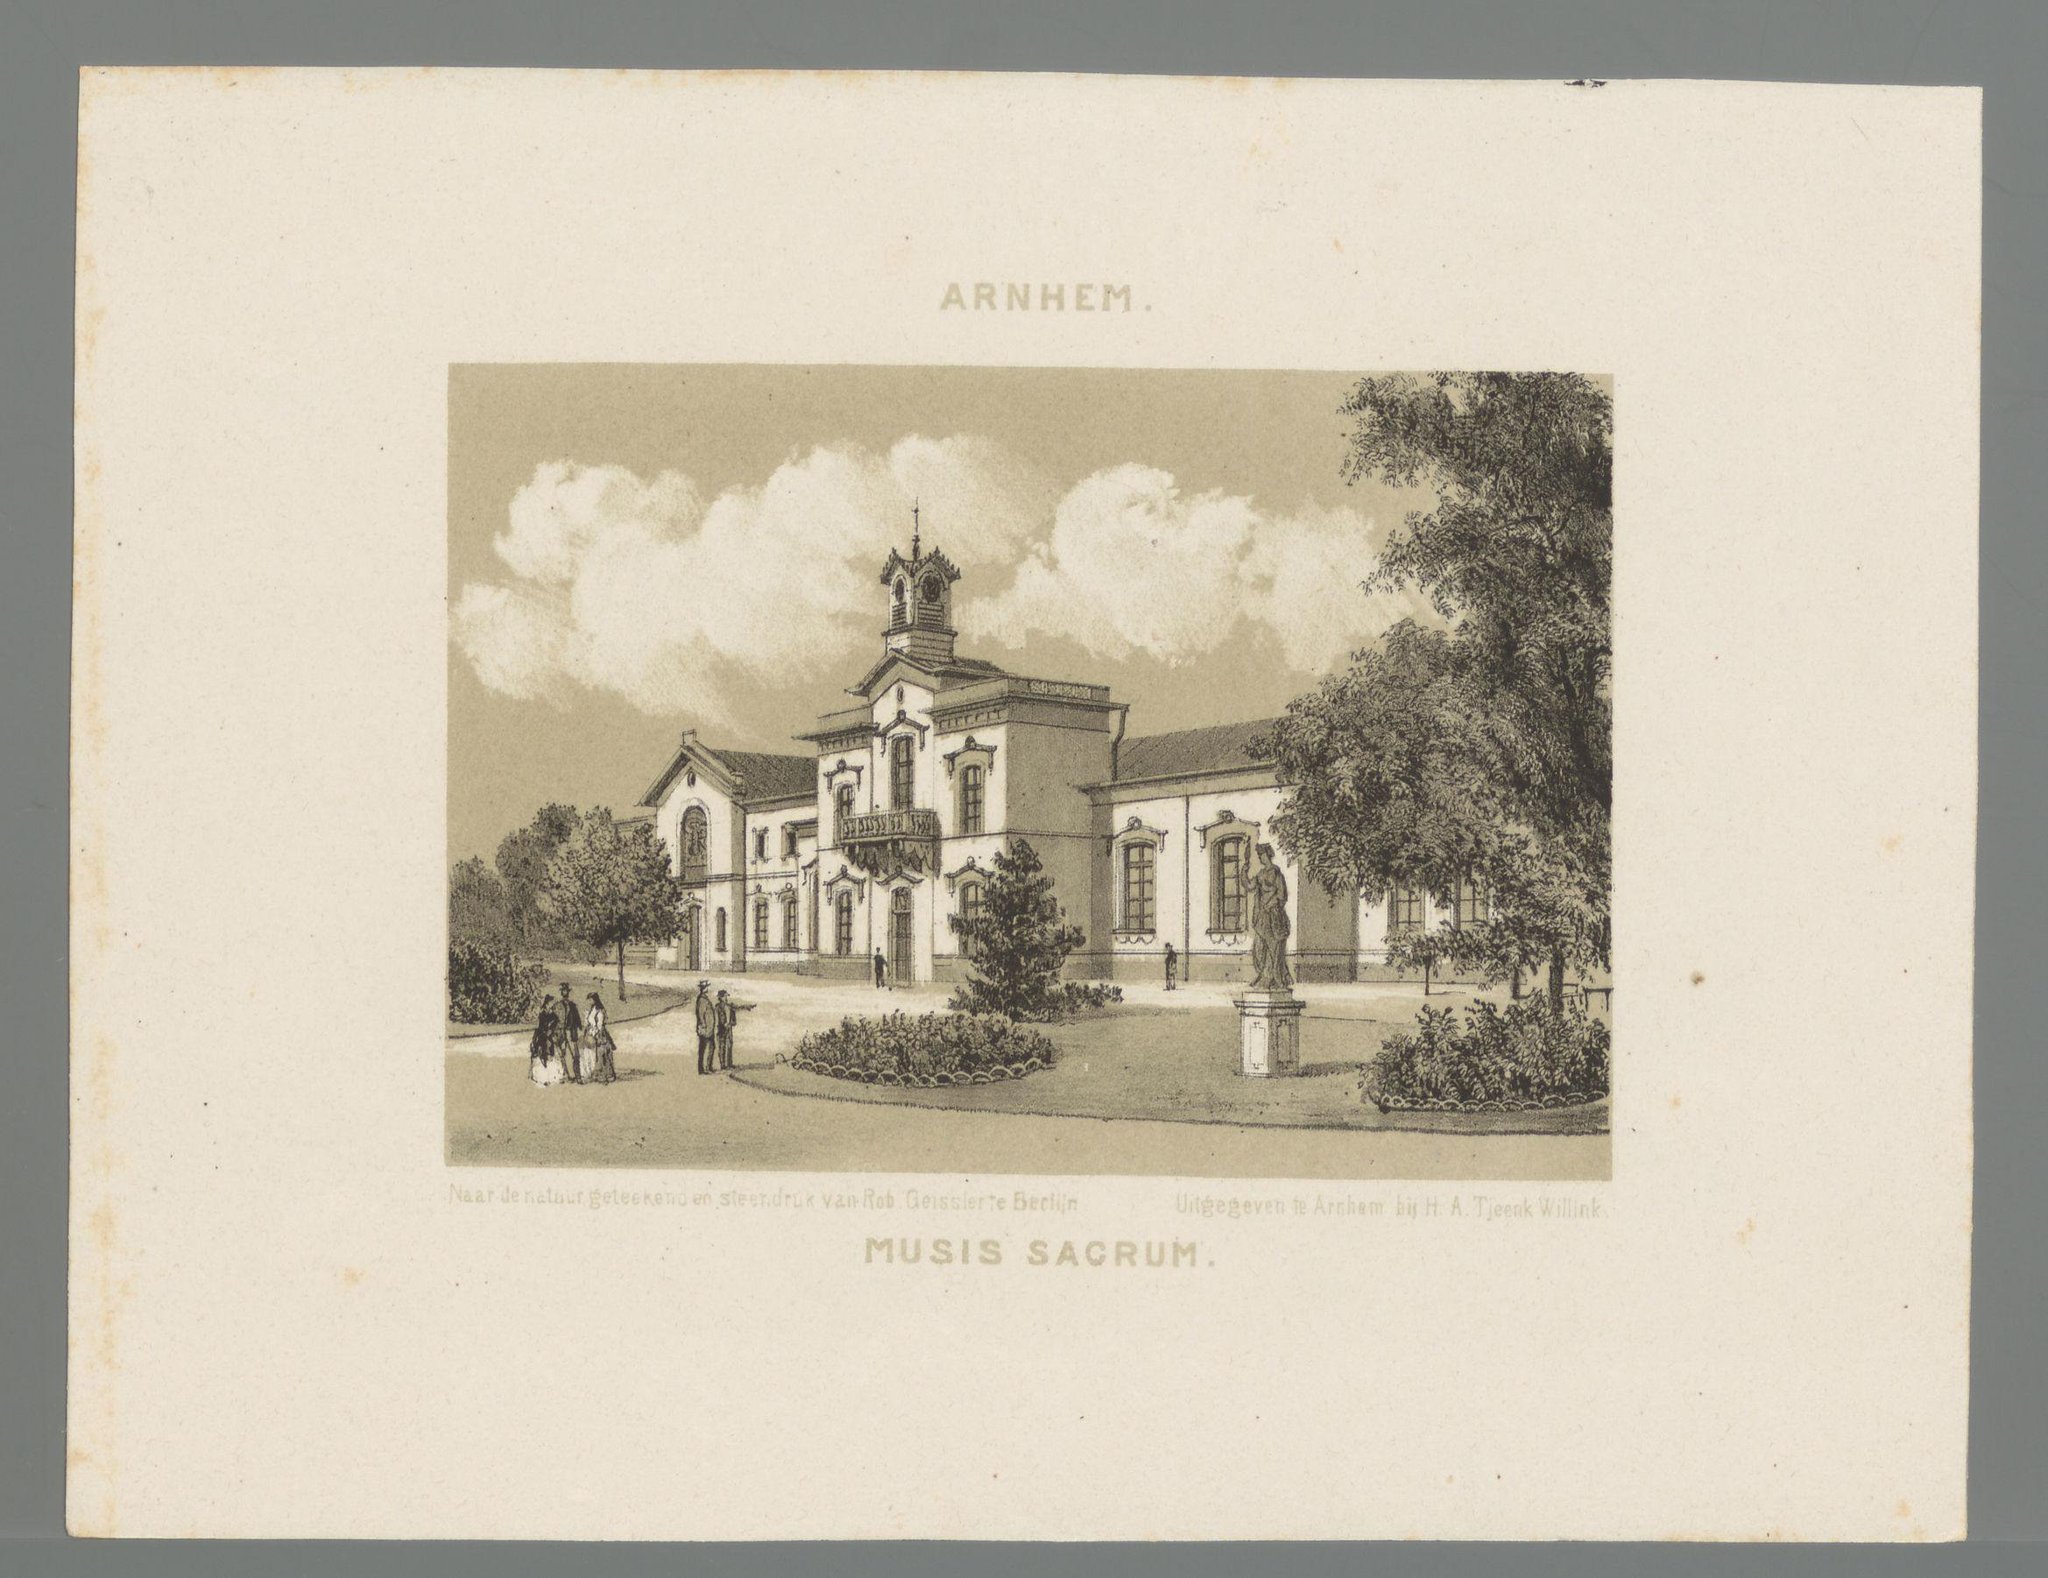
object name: print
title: Gezichten op Arnhem en zijn omgeving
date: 1865-1875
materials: paper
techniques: tone lithography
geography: arnhem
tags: theatre (building), arnhem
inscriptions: collector's mark: Lugt 2228